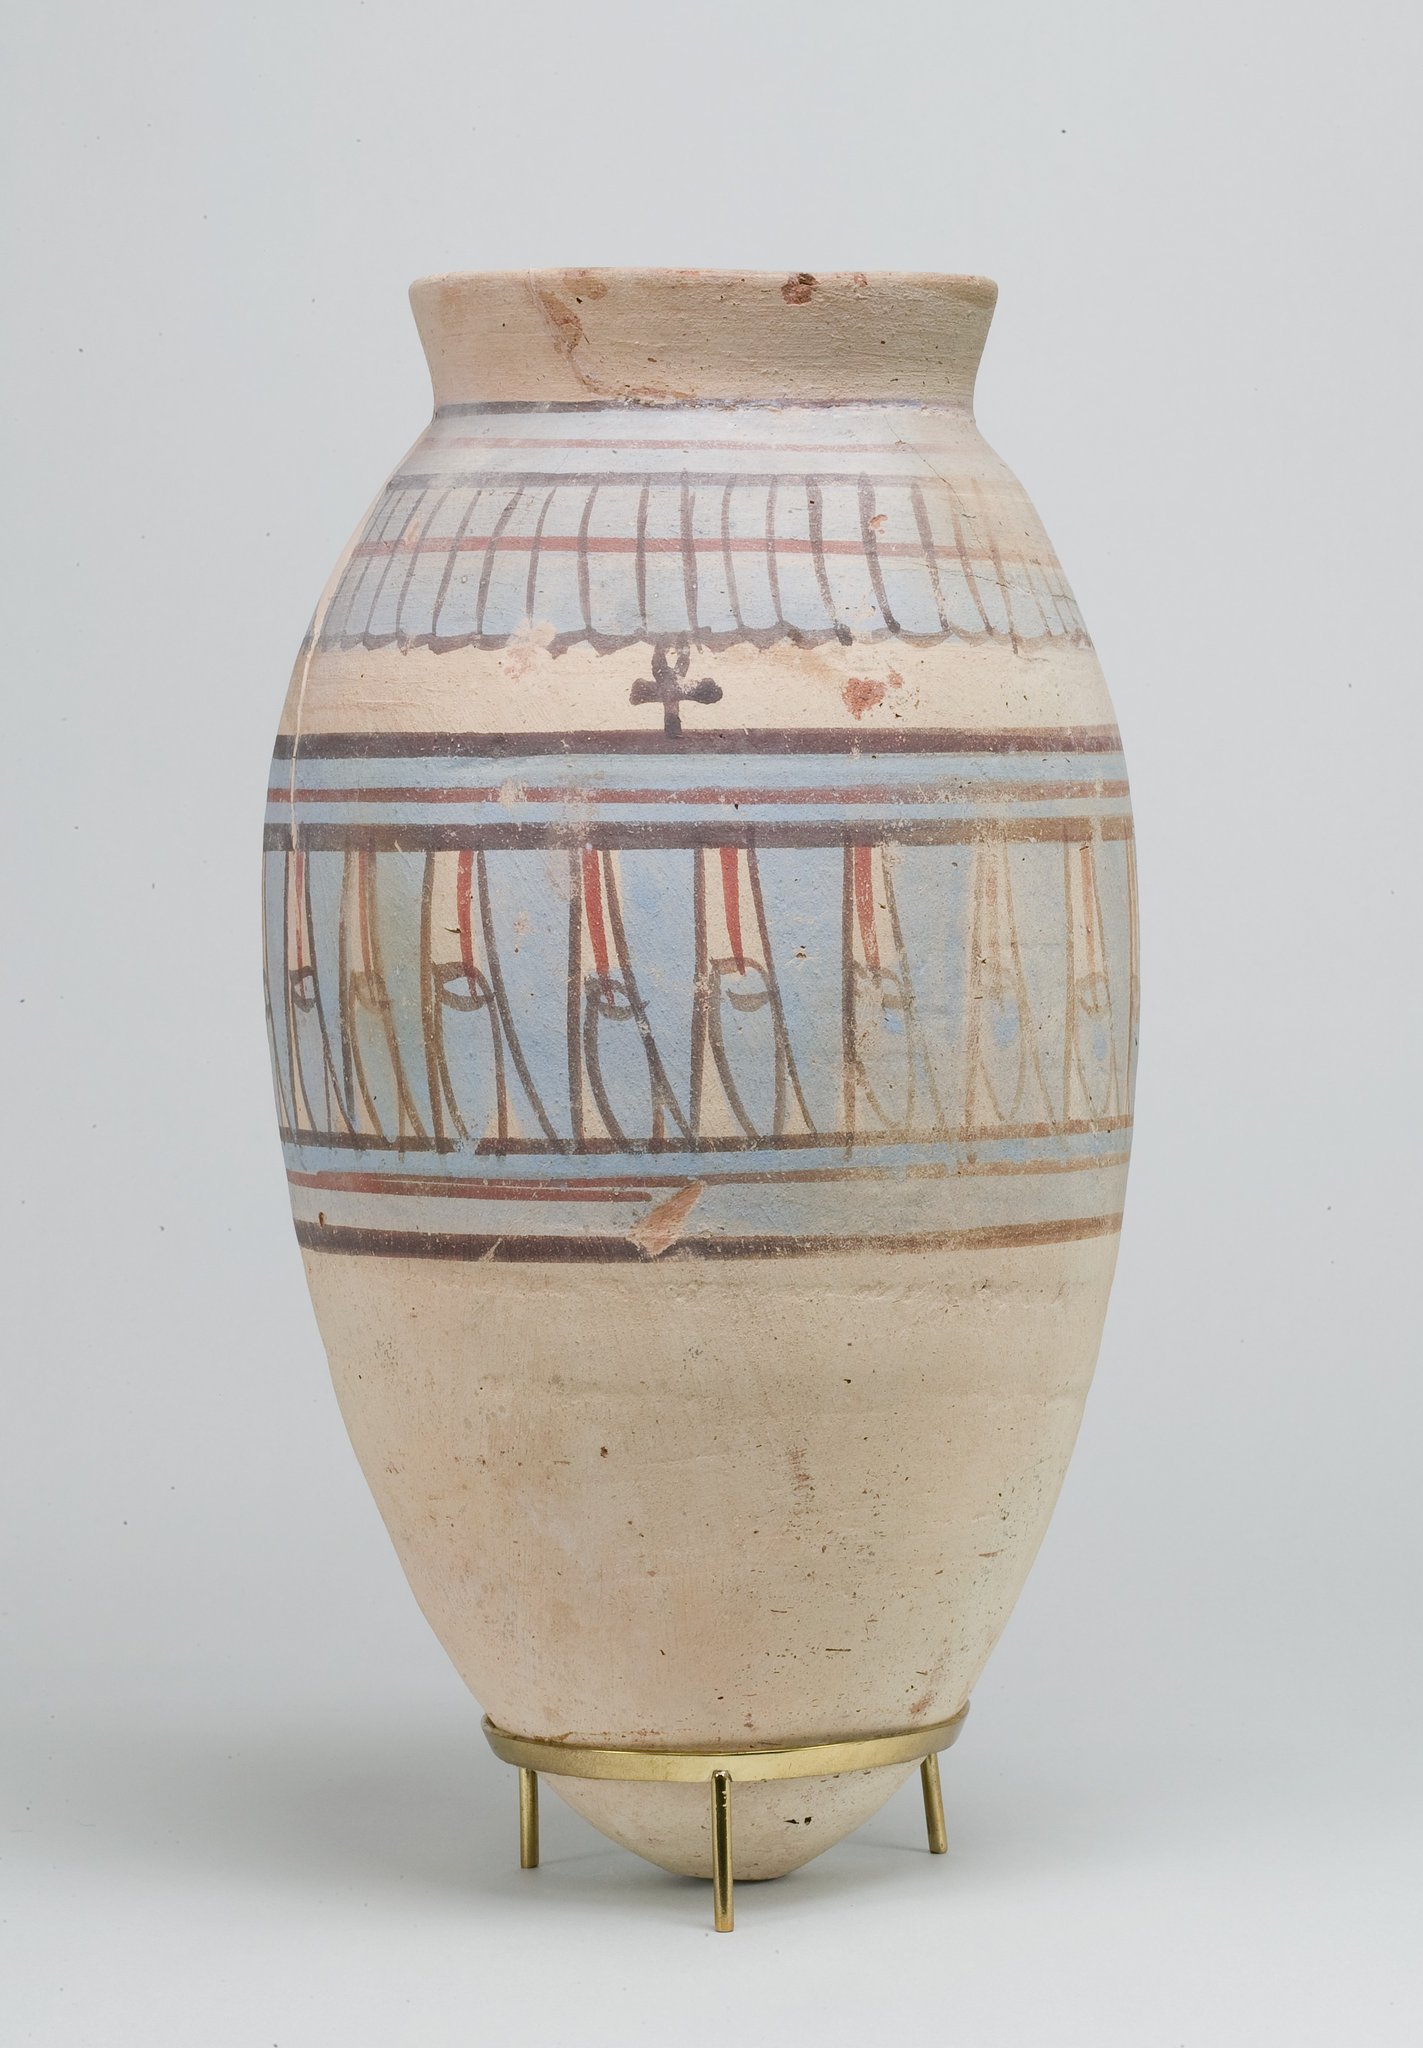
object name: jar, blue painted ware, ankh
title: Blue-painted Jar from Malqata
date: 1390-1352 BCE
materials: paint, pottery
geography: egypt